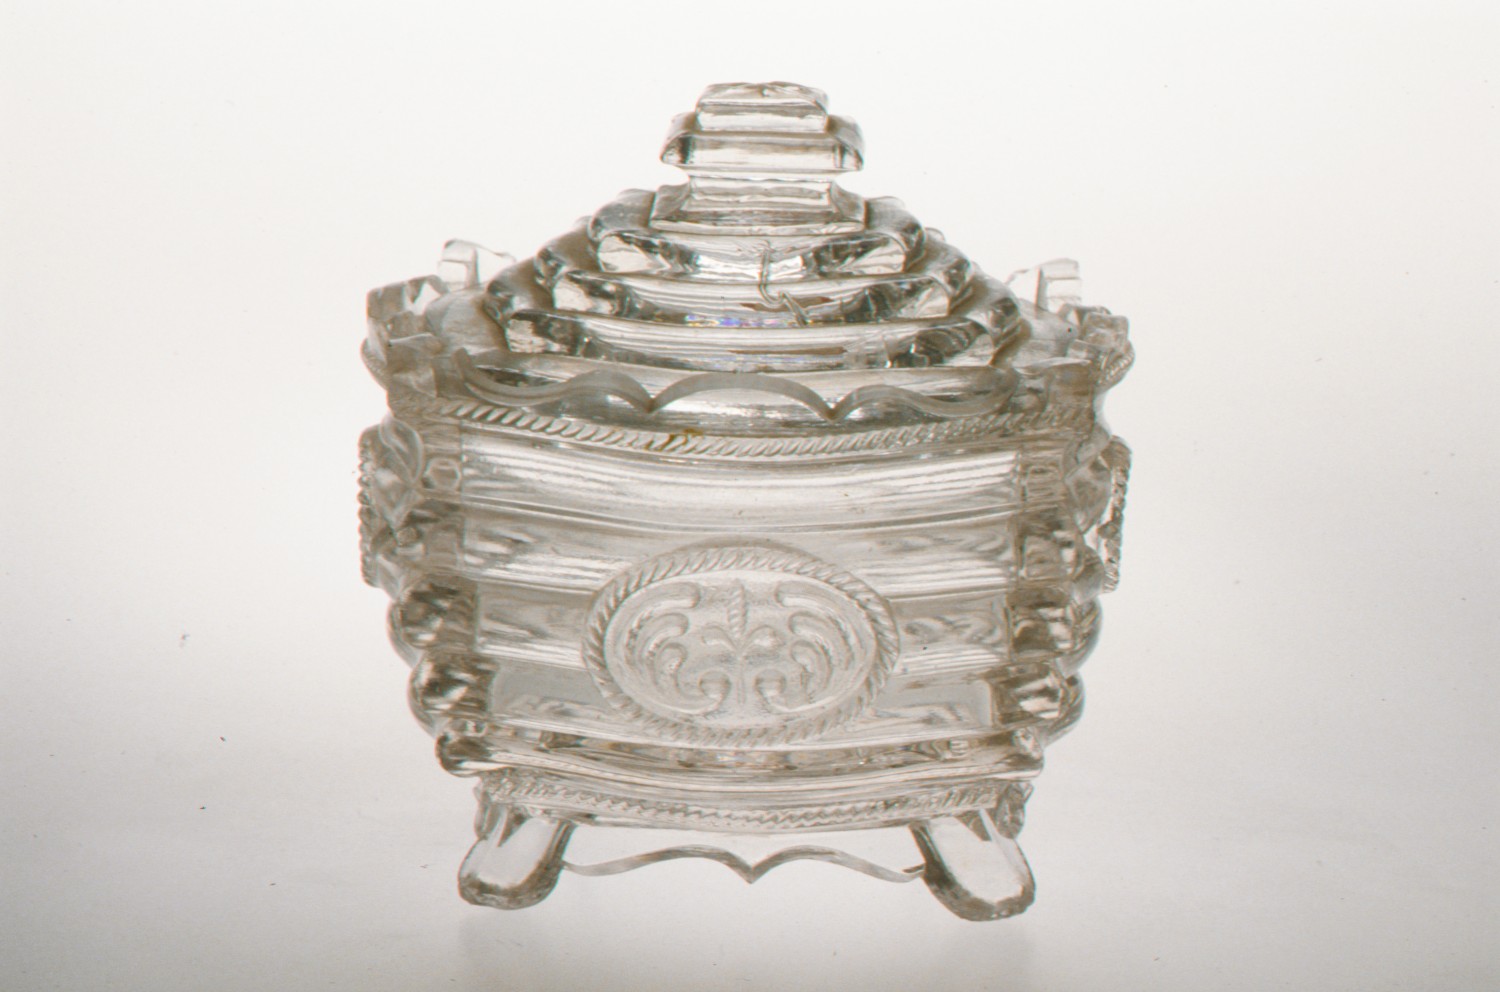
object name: sugar bowl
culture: american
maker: new england glass company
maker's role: maker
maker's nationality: american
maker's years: 1818-1888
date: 1827-1835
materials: glass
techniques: pressed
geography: united states